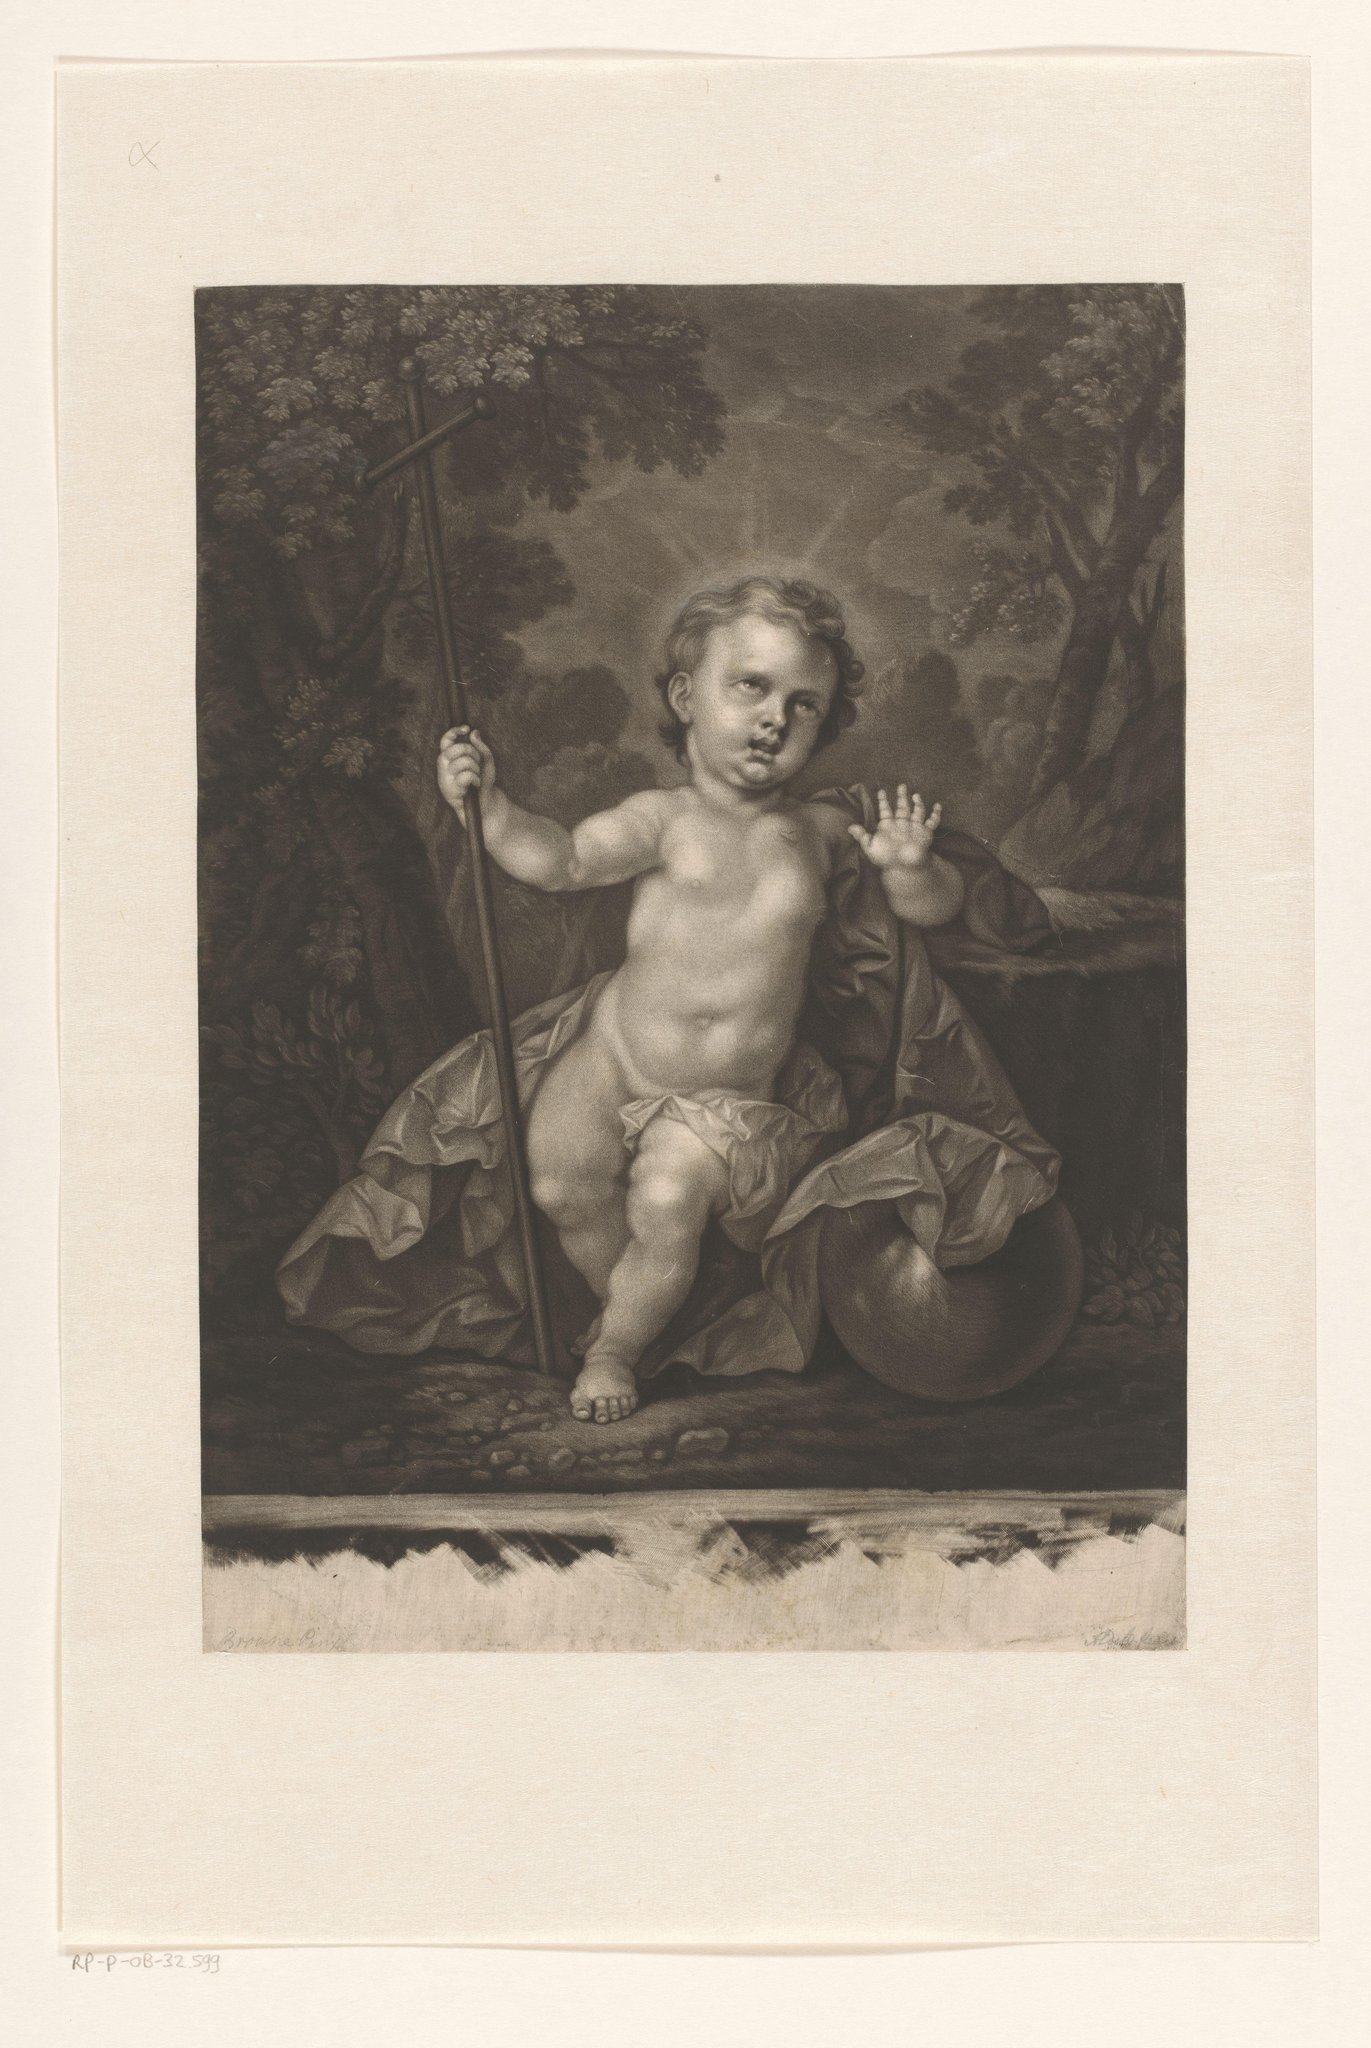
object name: print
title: Christuskind als Salvator Mundi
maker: james mcardell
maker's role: print maker, publisher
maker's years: 1728-1765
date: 1745-1765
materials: paper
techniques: mezzotint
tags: christ-child (with attributes), 'salvator mundi', making a blessing gesture; an orb in his hand or at his feet - dd - christ beardless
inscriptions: collector's mark: Lugt 240